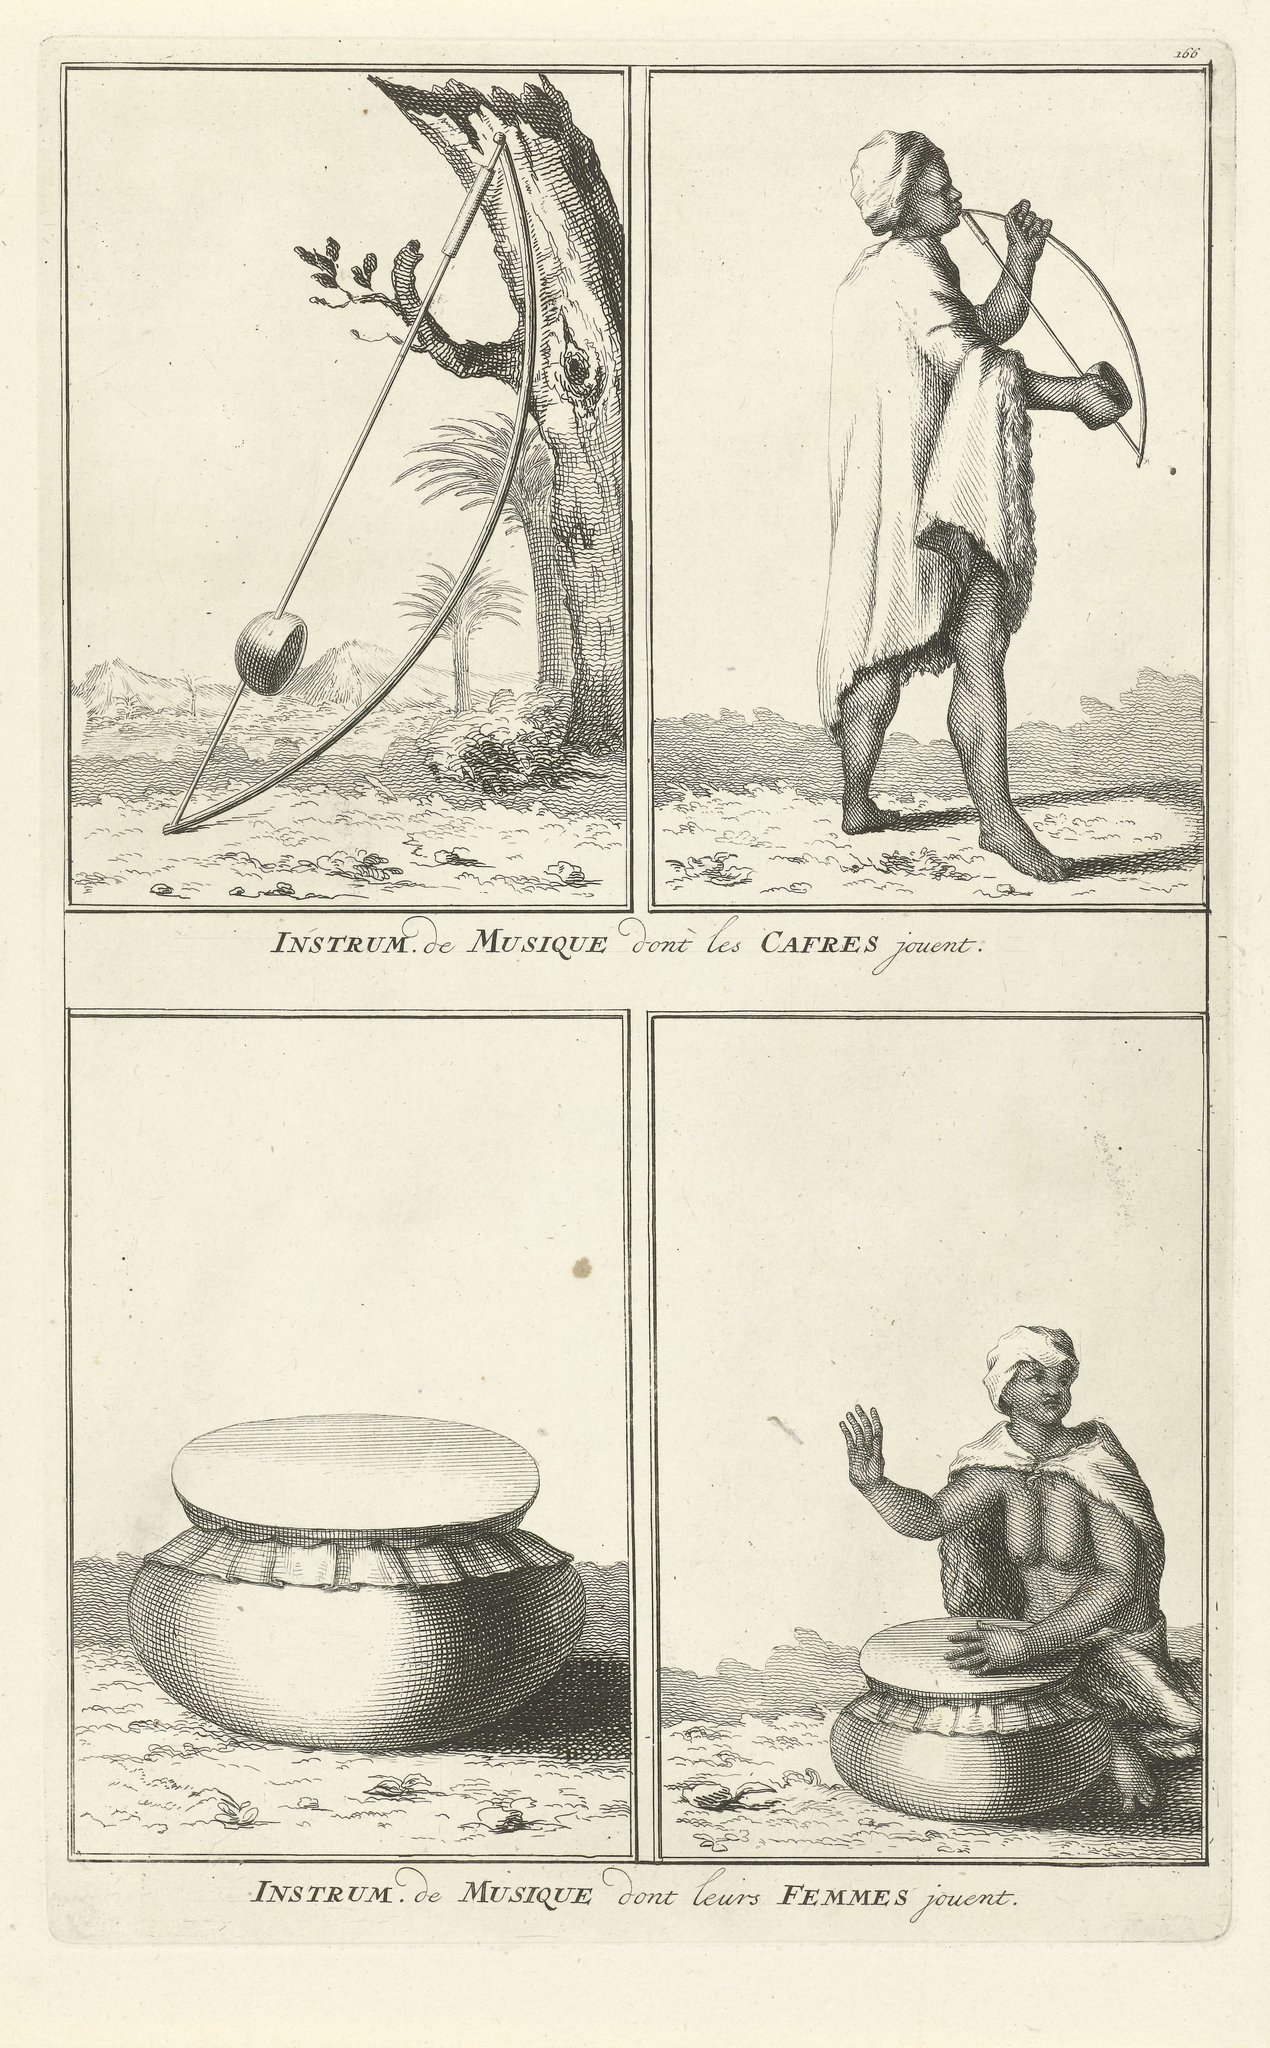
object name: print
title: Afrikaanse muziekinstrumenten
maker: bernard picart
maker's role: draughtsman, print maker, publisher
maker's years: 1673-1733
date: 1728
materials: paper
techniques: engraving, etching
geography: amsterdam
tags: drum (musical instrument), wind instruments, khoikhoi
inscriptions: collector's mark: Lugt 2228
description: Prent ook gebruikt in: Picart, Bernard. Naaukeurige beschryving der uitwendige godtsdienst-plichten, kerk-zeden en gewoontens van alle volkeren der waereldt, deel IV. [Vertaald in het Nederlands door] Moubach, Abraham. Den Haag, Amsterdam, Rotterdam: Rutgert Alberts, Hermannus Uytwerf, Jan Daniel Beman, Isaac van der Kloot, 1727-1738.